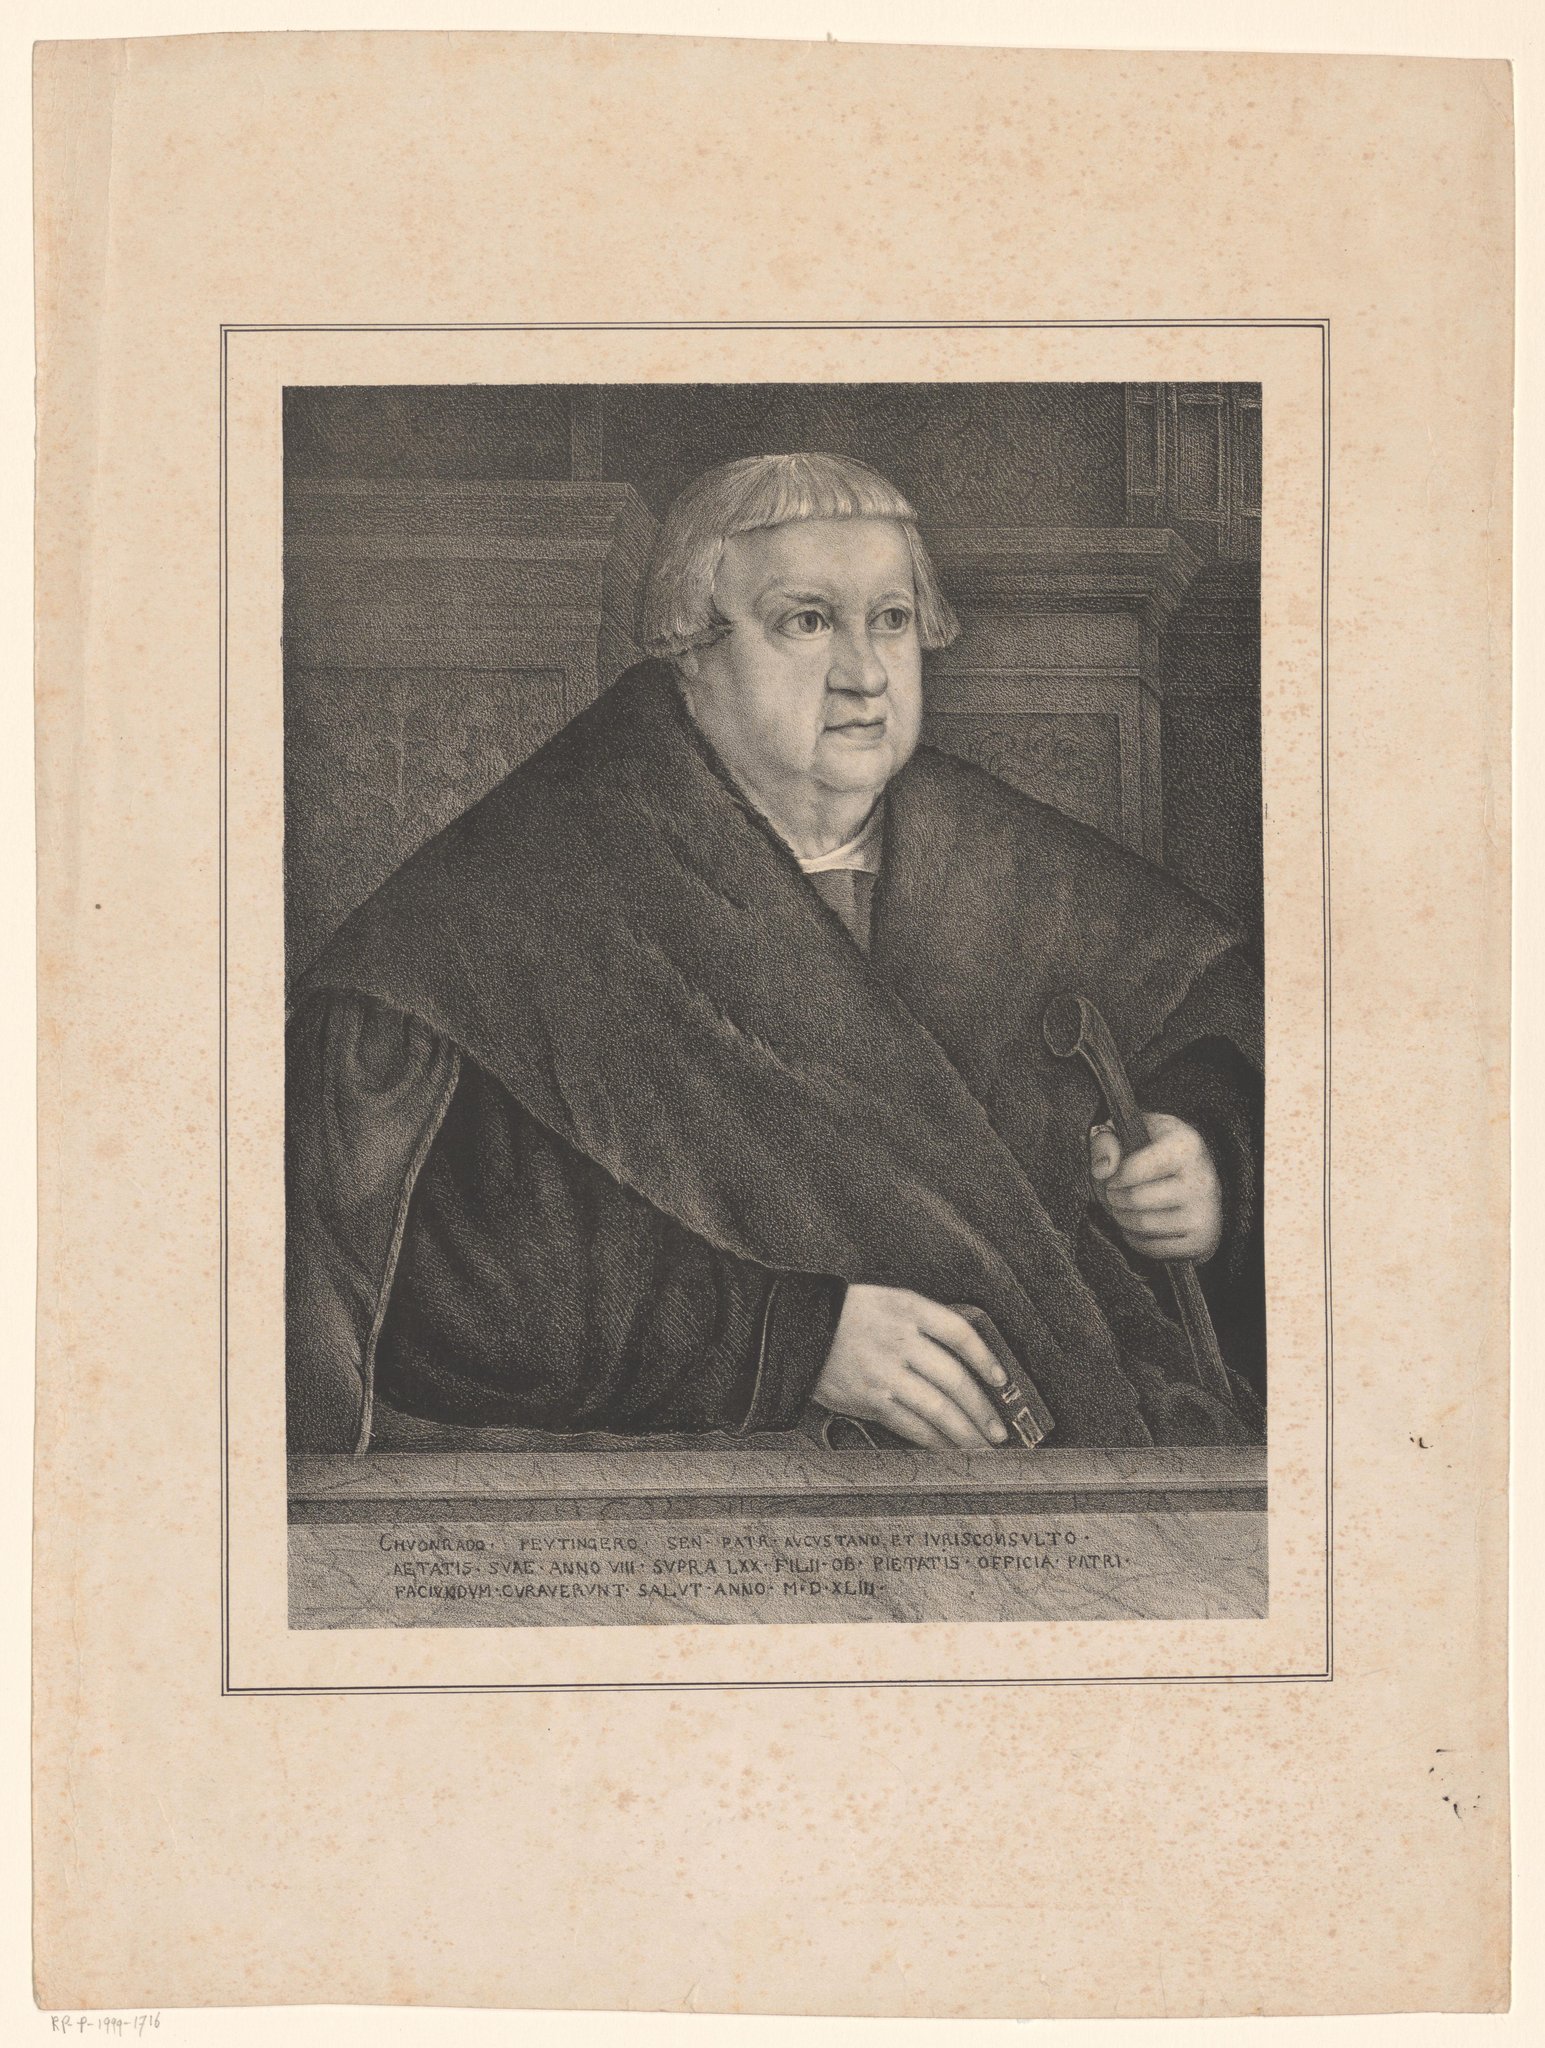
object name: print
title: Portret van Conrad Peutinger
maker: Anonymous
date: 1820-1899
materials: paper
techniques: lithograph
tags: augsburg, mayor, conrad peutinger, adult man, historical persons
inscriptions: collector's mark: Lugt 2228, collector's mark: Lugt 4100, inscription: ‘AP 16217’